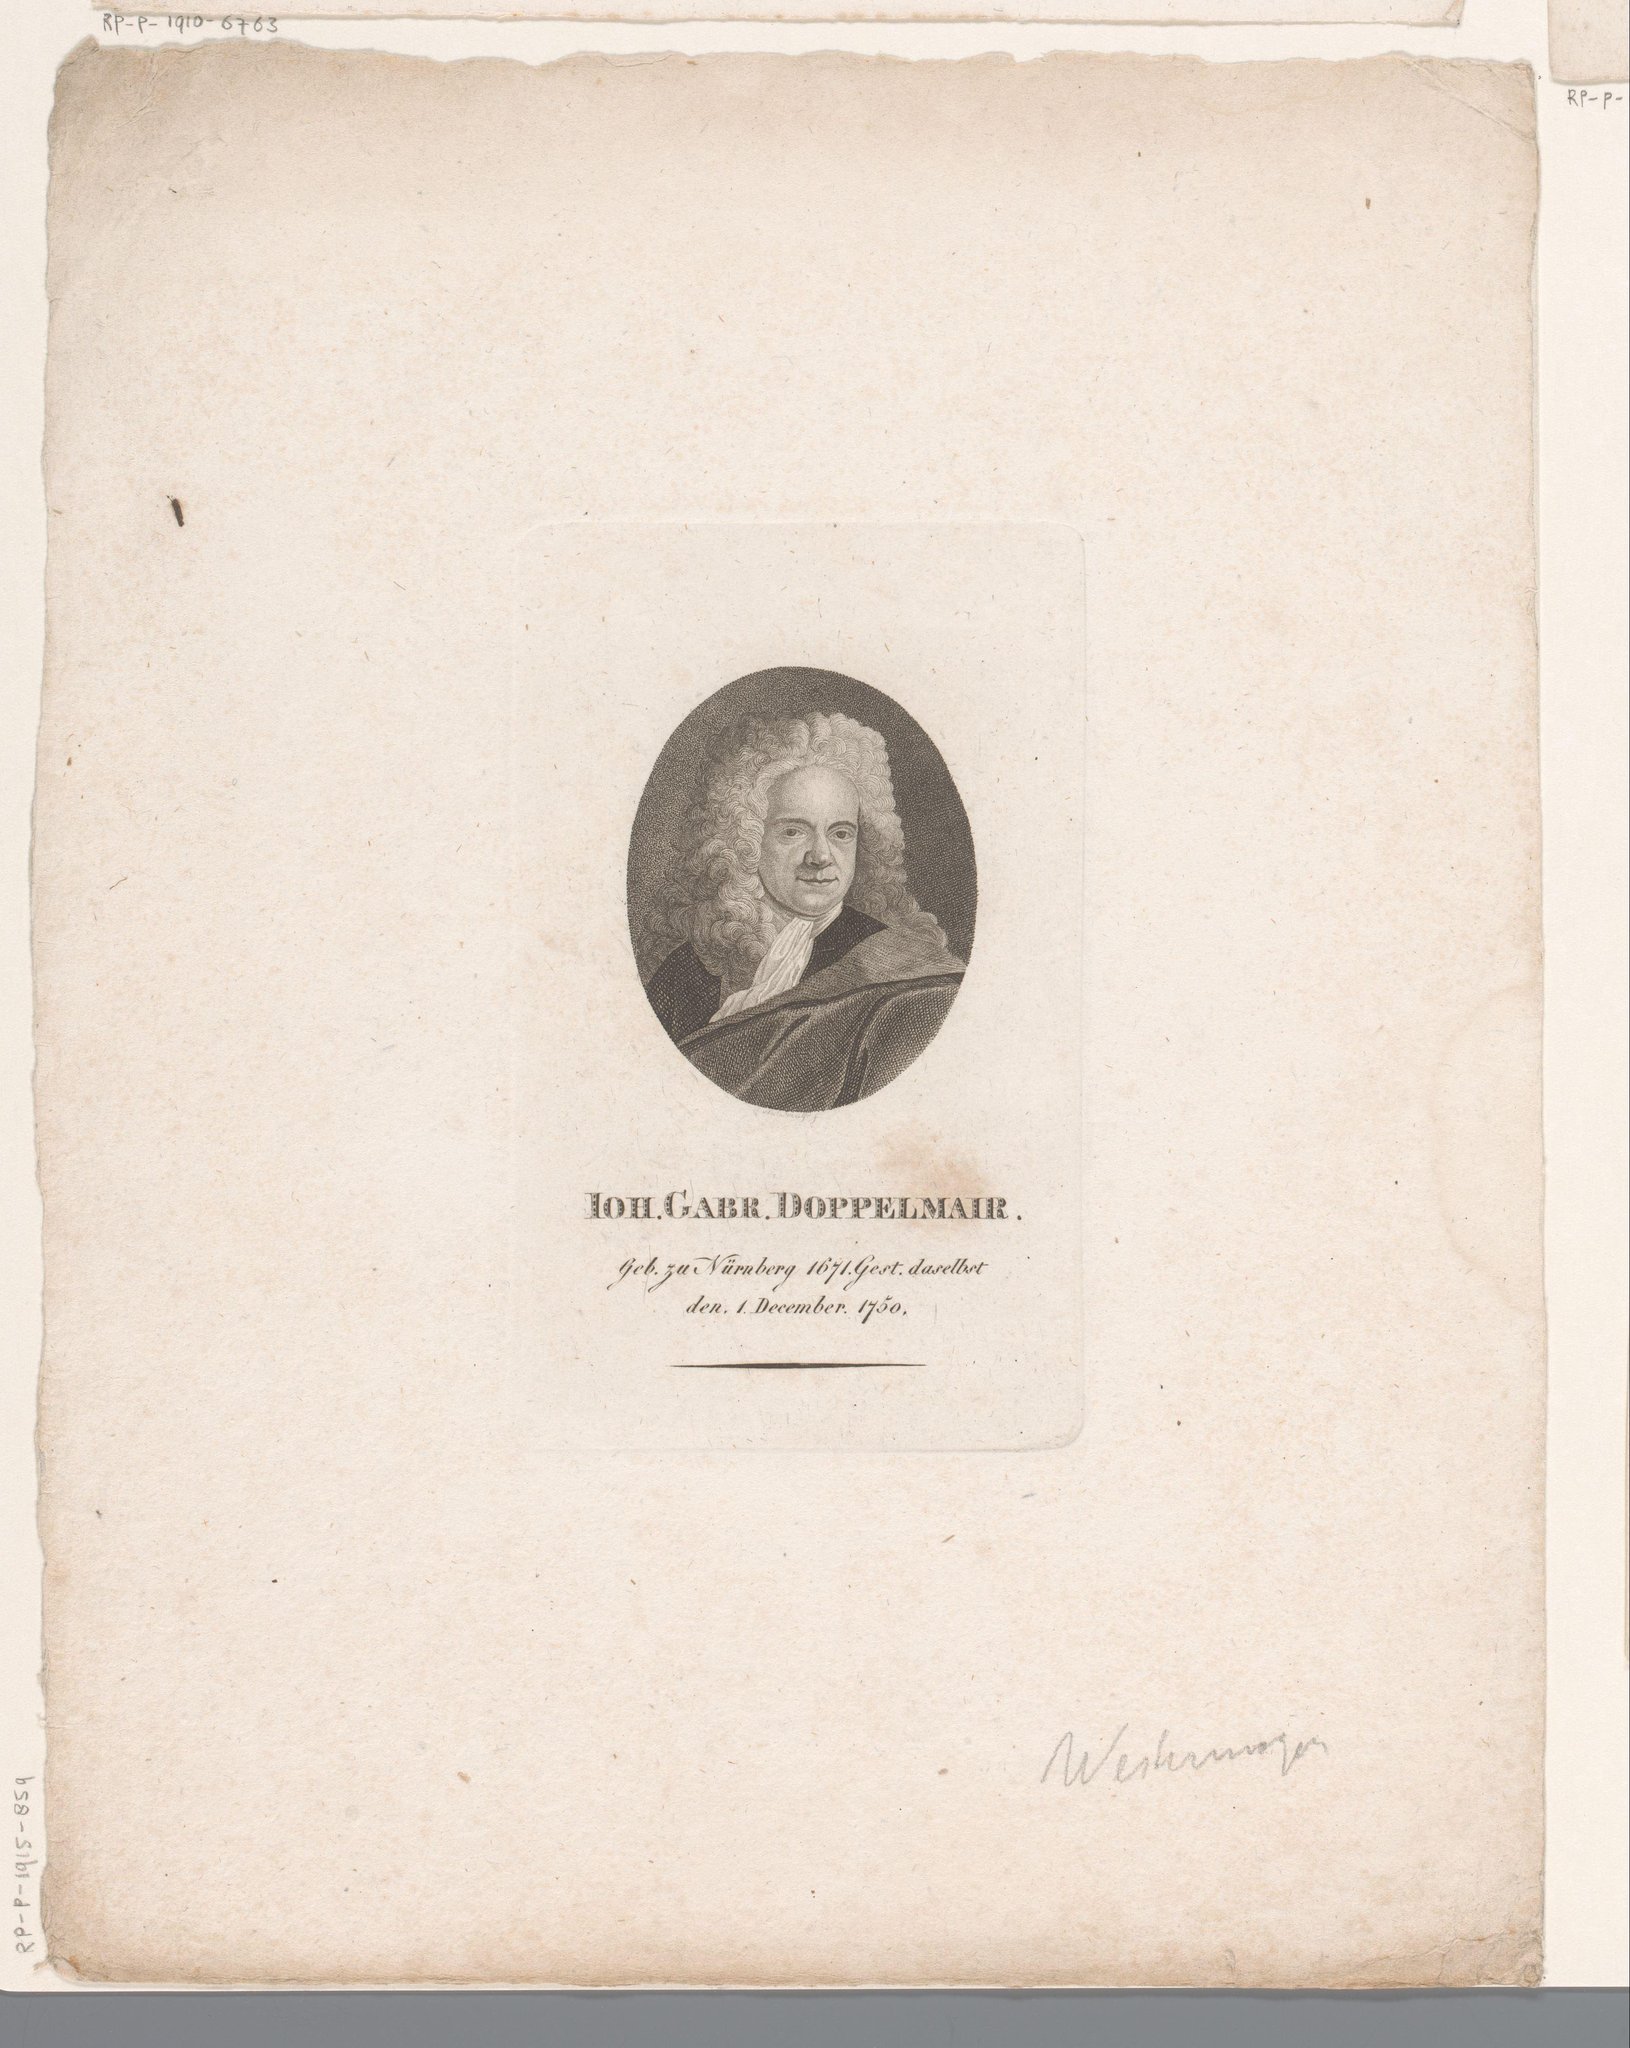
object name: print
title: Portret van Johann Gabriel Doppelmayr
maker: konrad westermayr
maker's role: print maker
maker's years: 1765-1834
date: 1775-1834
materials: paper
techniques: engraving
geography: germany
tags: historical persons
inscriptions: collector's mark: Lugt 2228